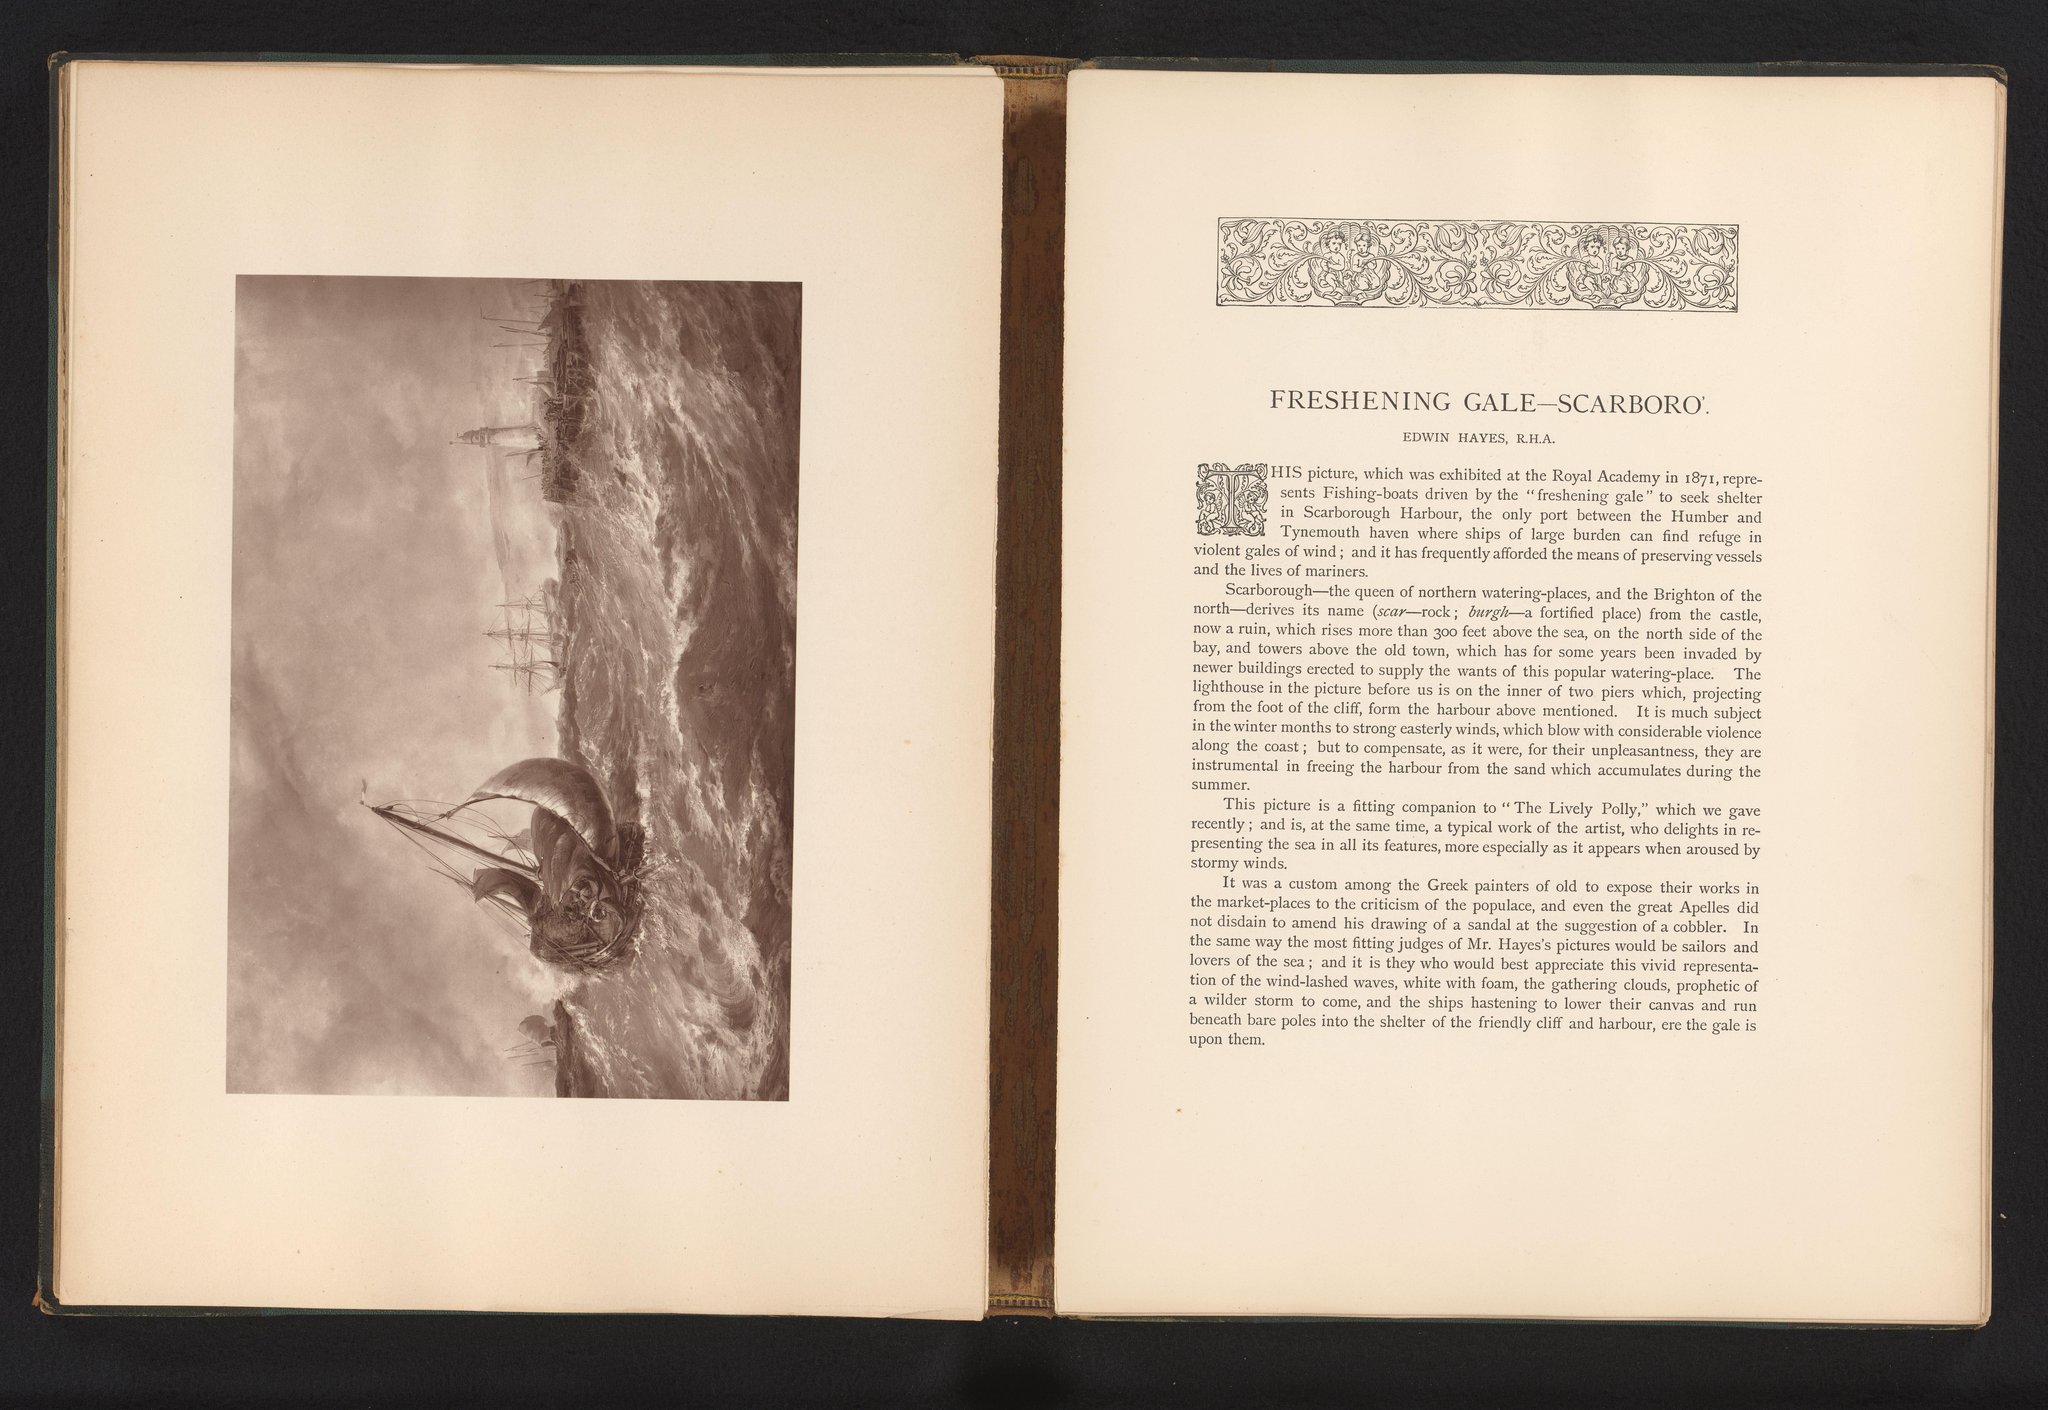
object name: photomechanical print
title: Reproductie van een schilderij van Freshening gale, Scarboro - Fishing boats returning to harbour door Edwin Hayes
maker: Anonymous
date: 1874-1879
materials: paper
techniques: woodburytype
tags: sailing-ship, sailing-boat, sea (seascape)